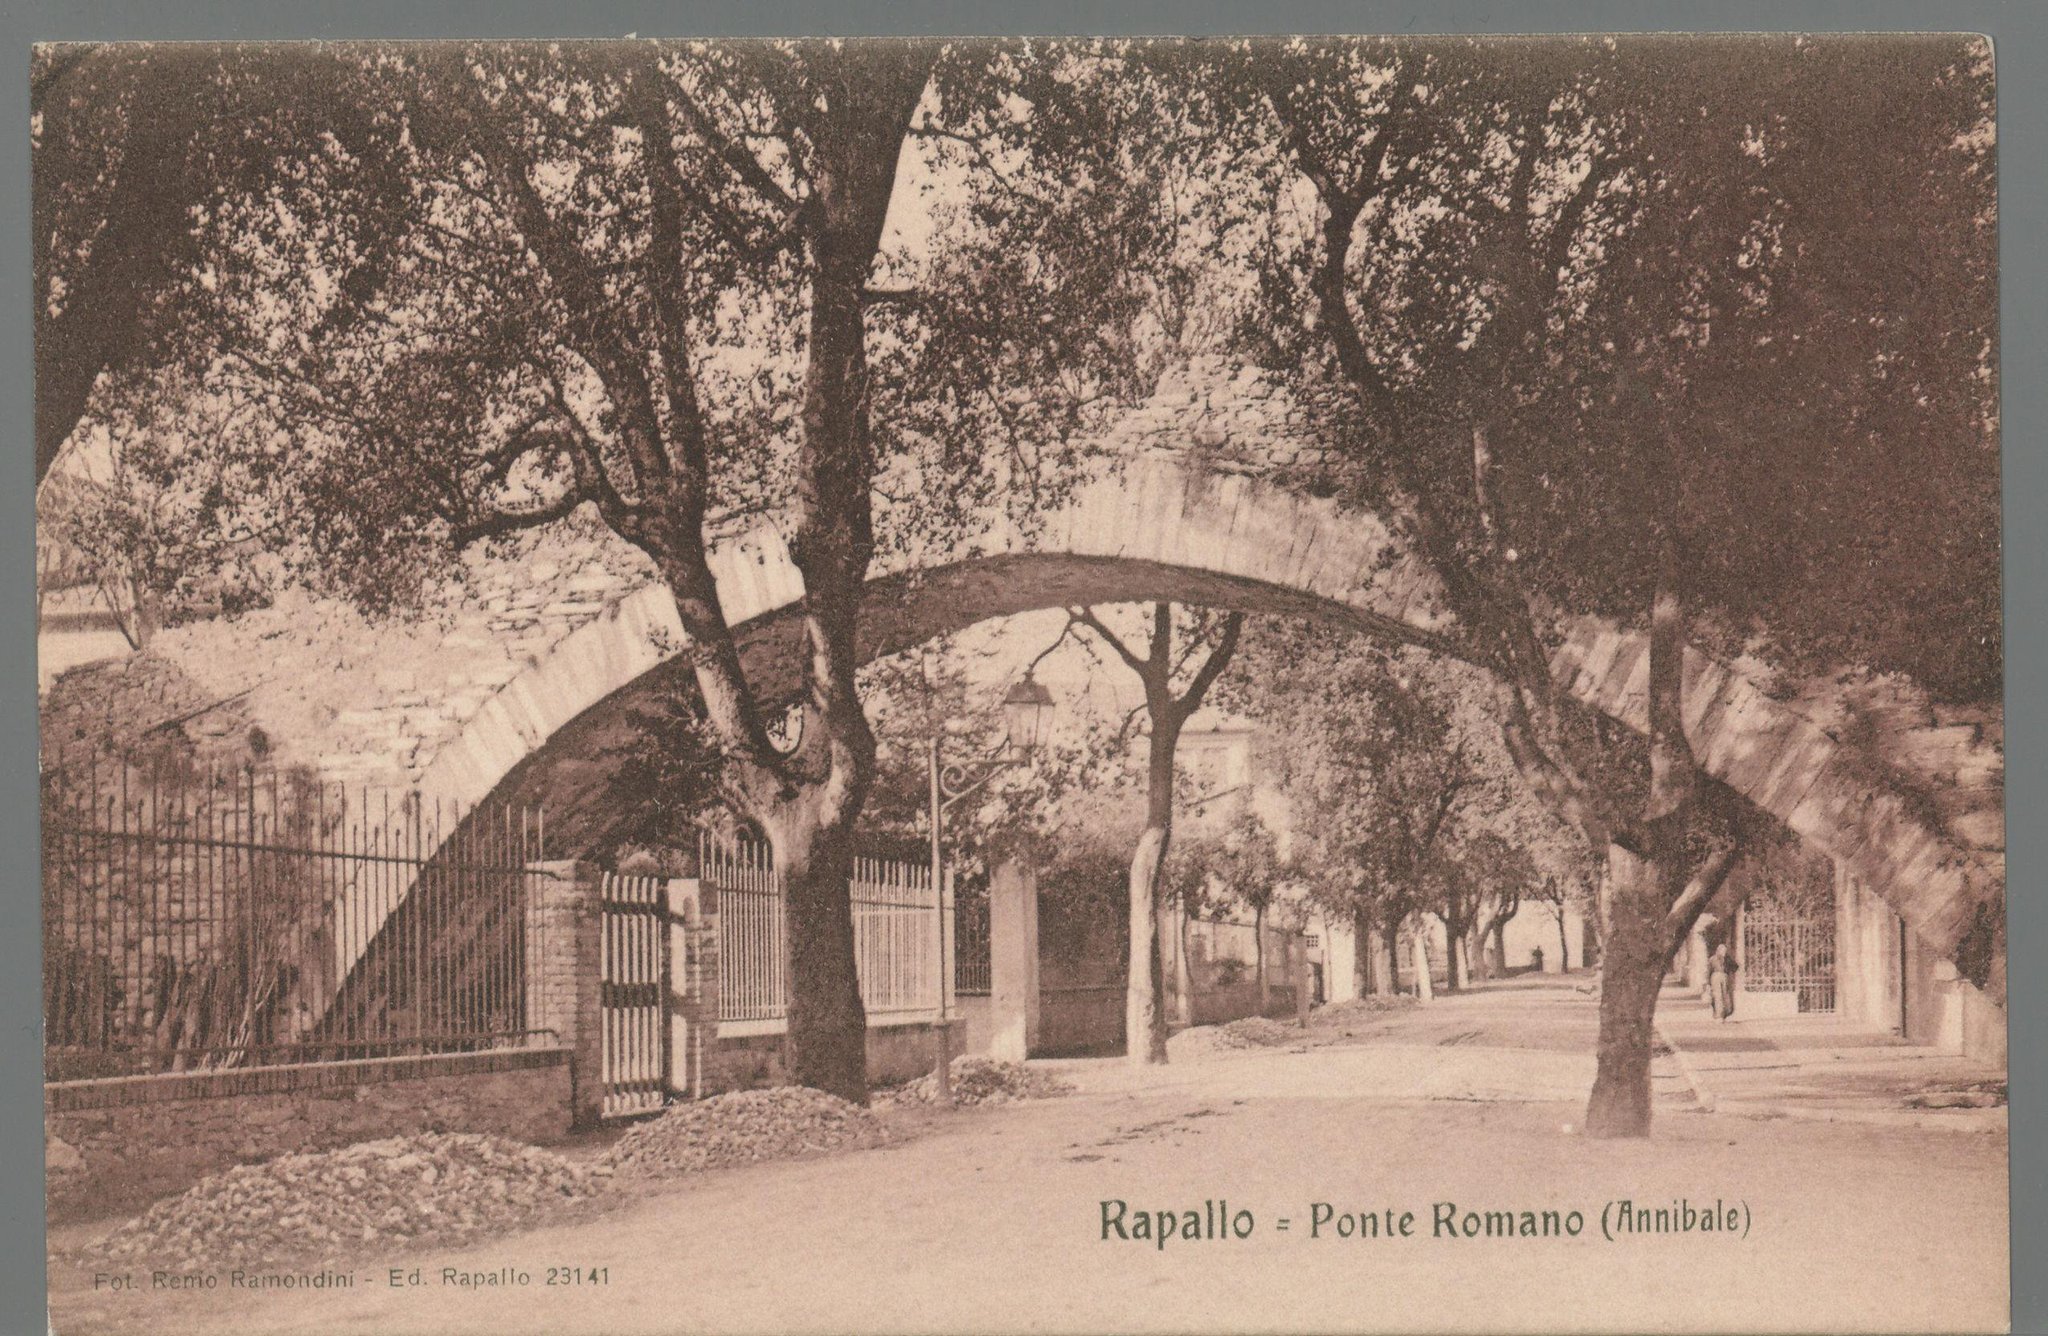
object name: photomechanical print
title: Rapallo. Ponte Romano (Annibale)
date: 1906-1909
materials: cardboard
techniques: photograph, writing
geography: rapallo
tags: city-view, and landscape with man-made constructions, bridge